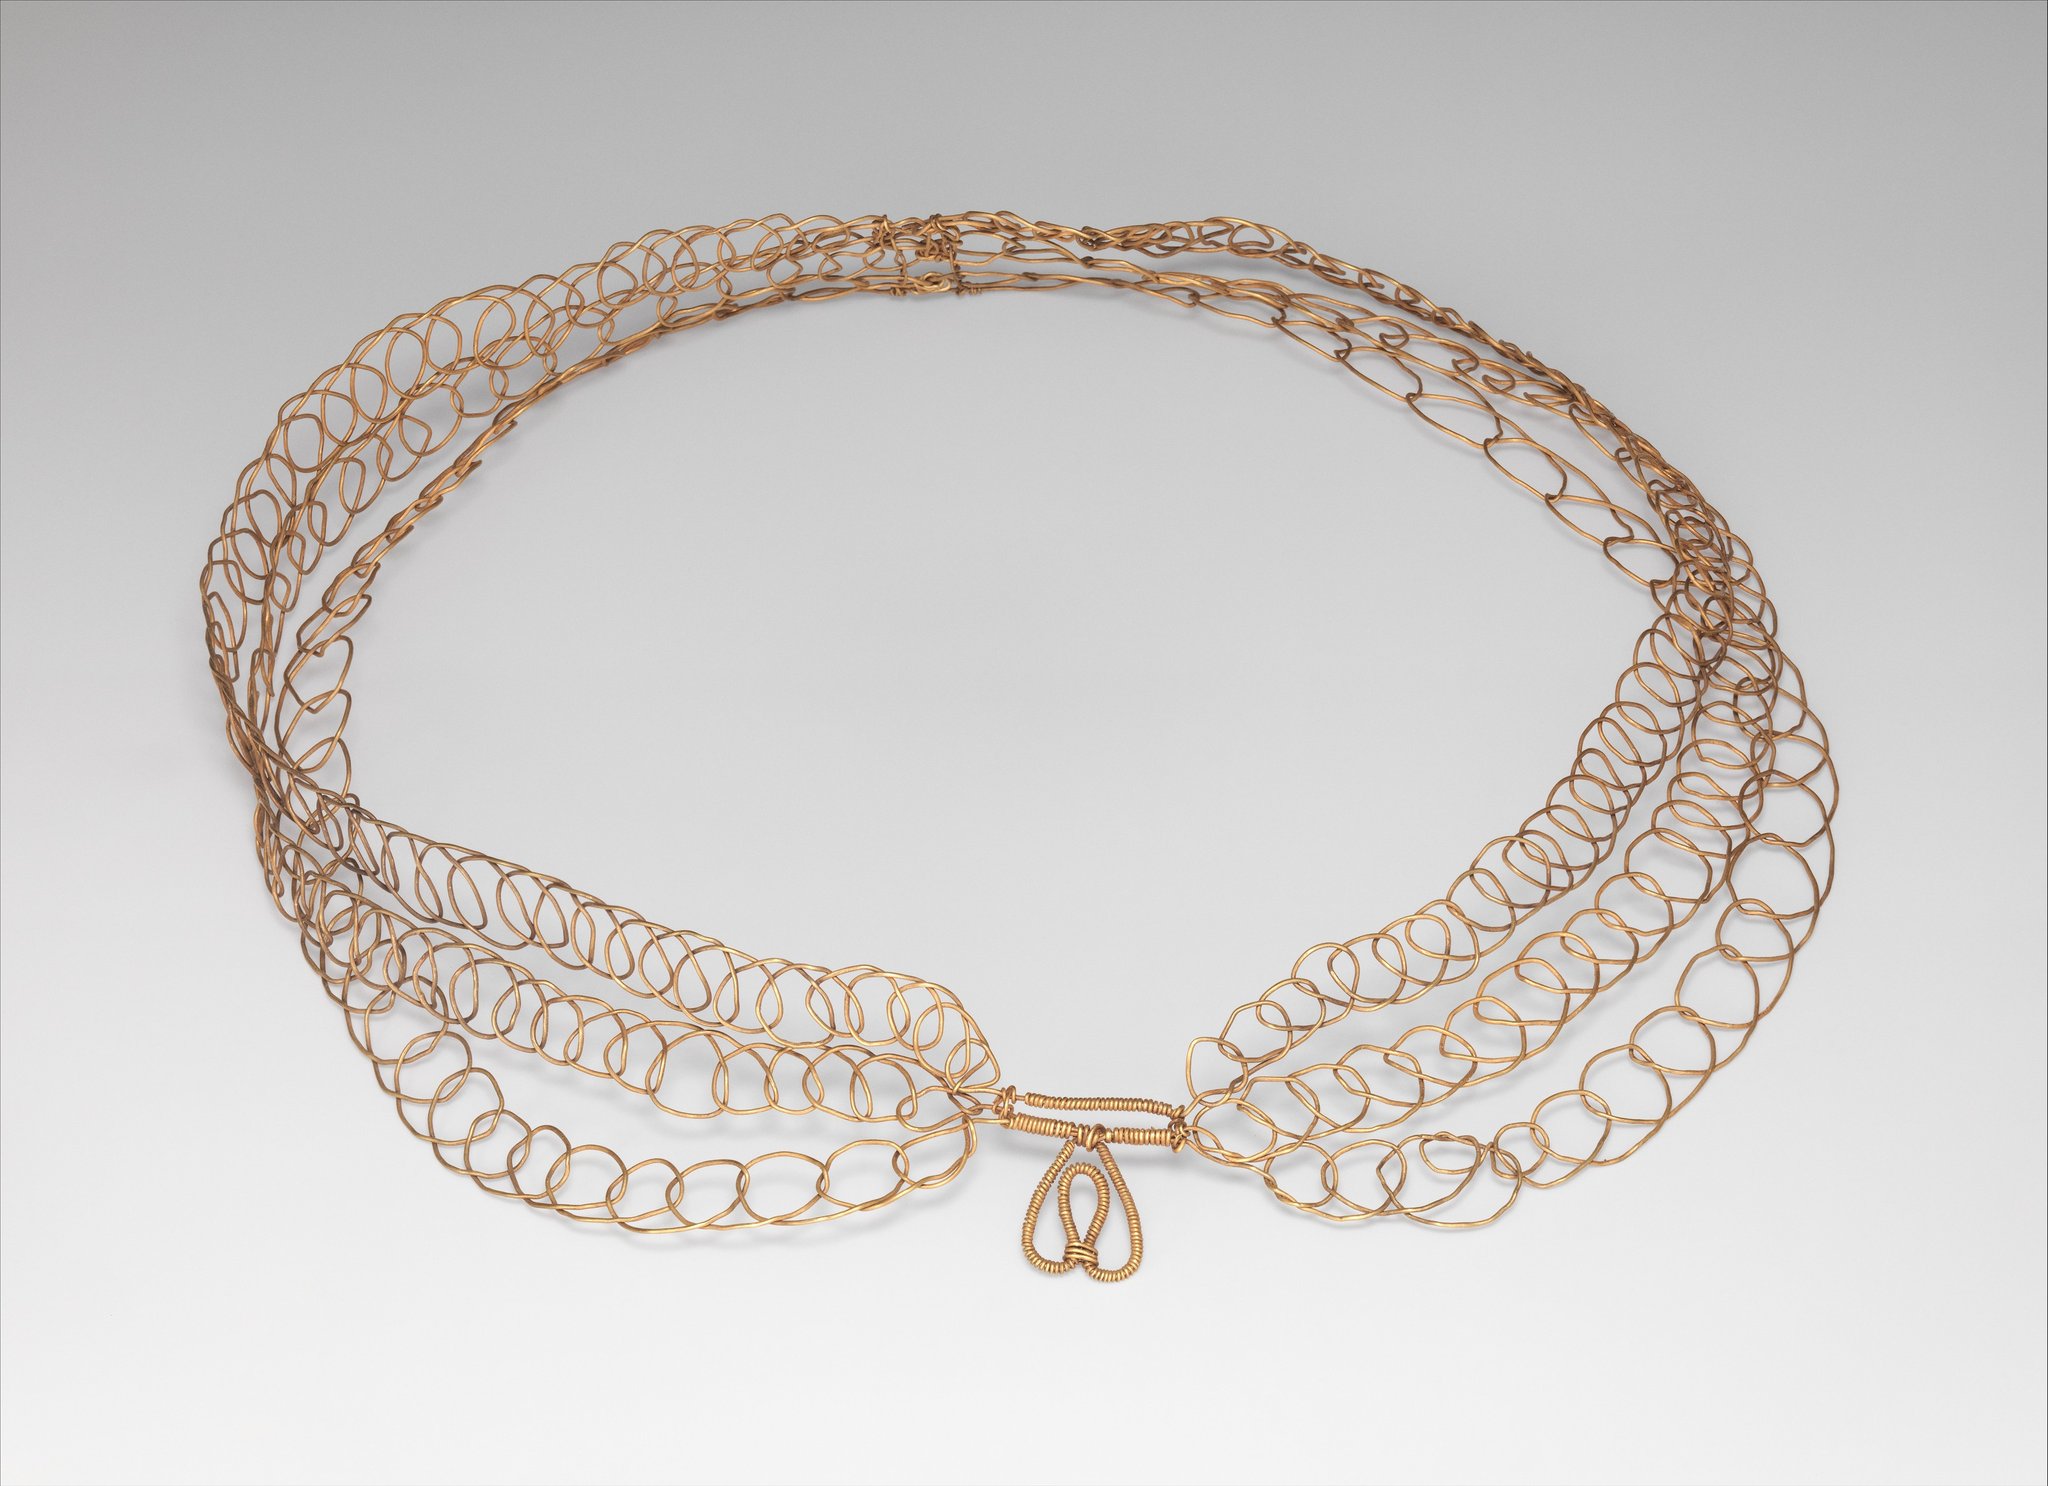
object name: diadem, senebtisi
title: Diadem of Senebtisi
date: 1859-1770 BCE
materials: gold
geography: egypt